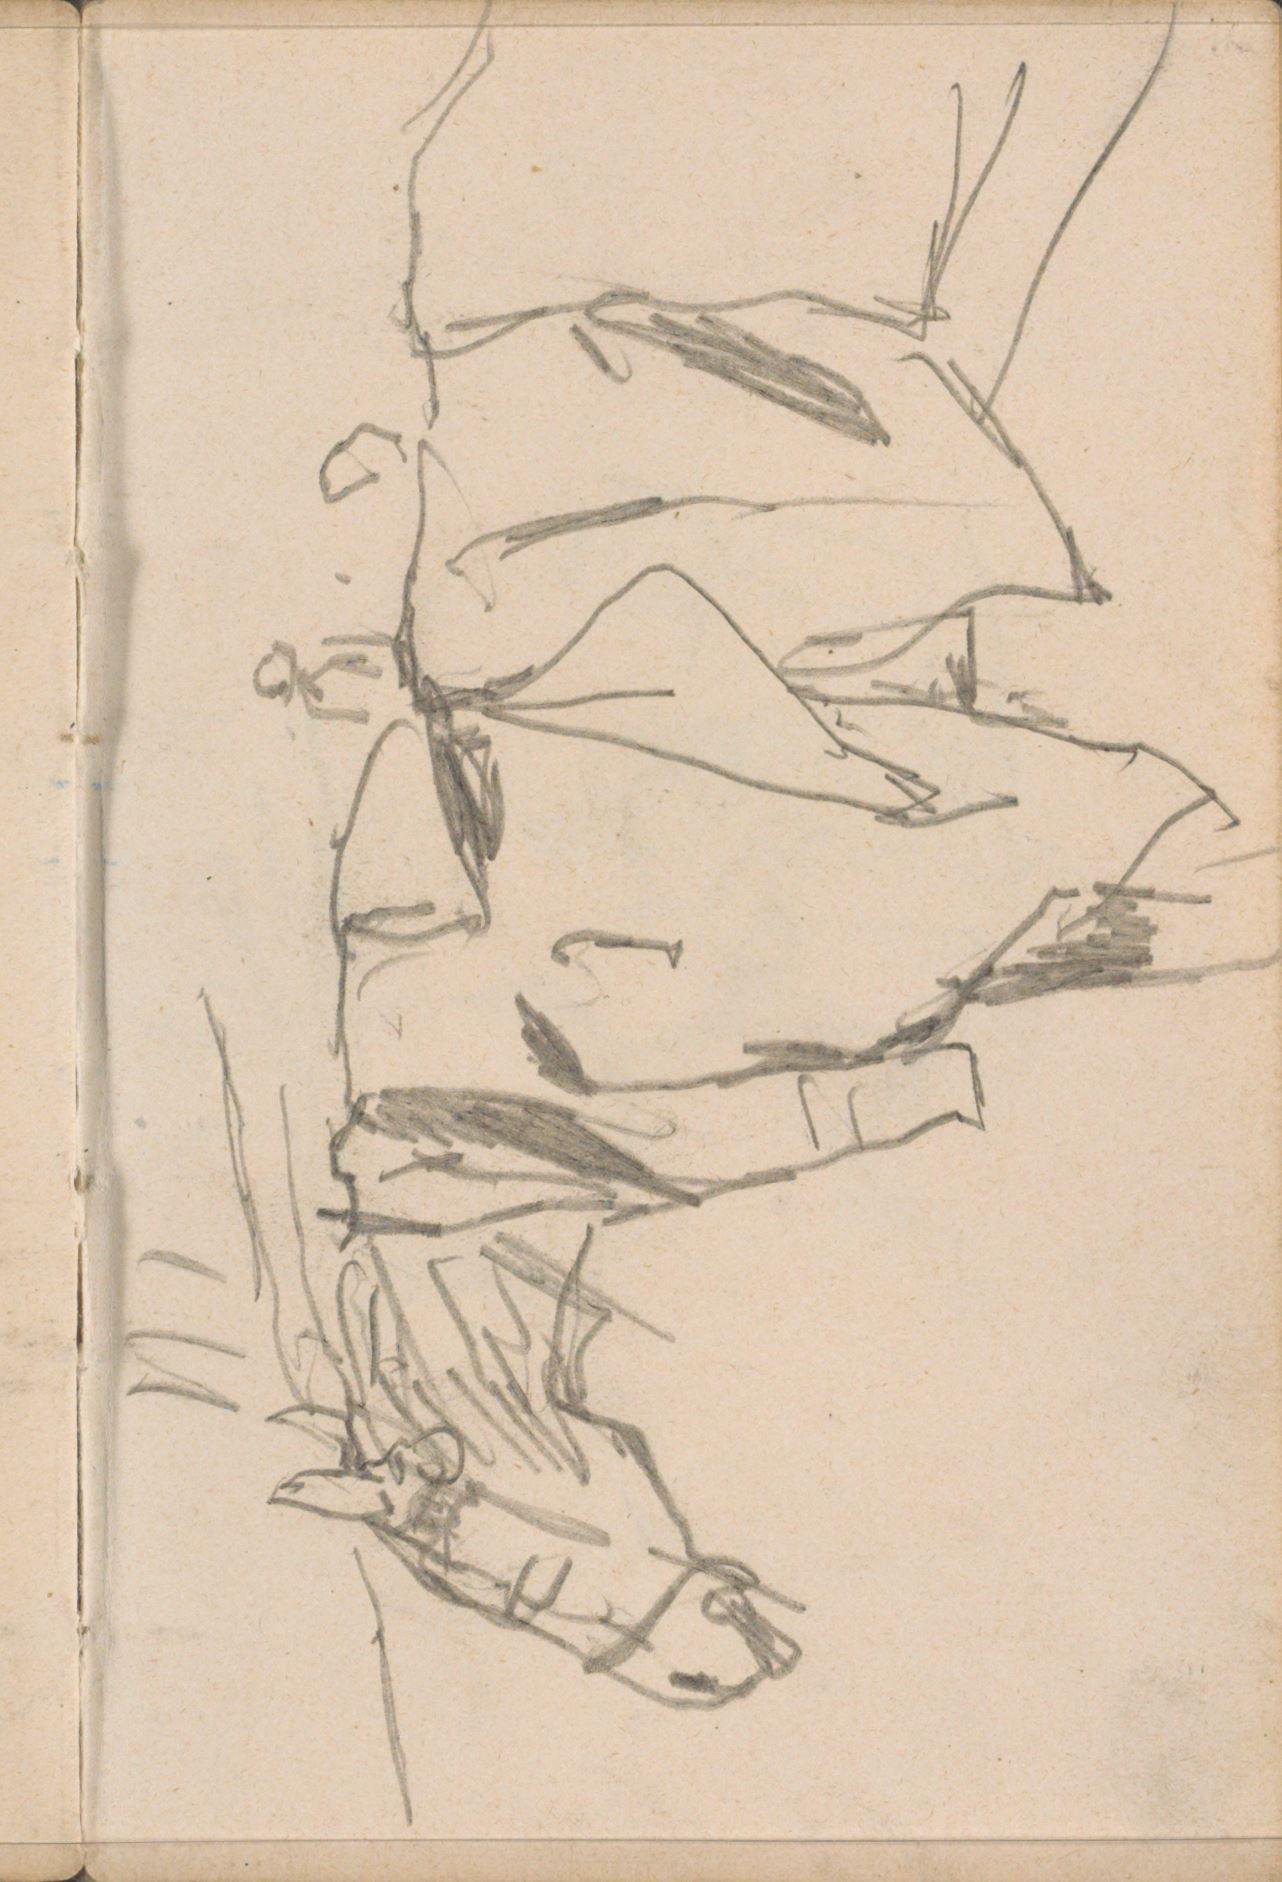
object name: sketchbook leaf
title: Aangespannen paard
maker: george hendrik breitner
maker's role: draughtsman, painter, print maker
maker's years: 1857-1923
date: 1909-1912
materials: paper, pencil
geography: amsterdam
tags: four-wheeled vehicle drawn by one animal, horse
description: Aangespannen paard. Pagina 22 uit een schetsboek met 46 bladen vervaardigd te Amsterdam.